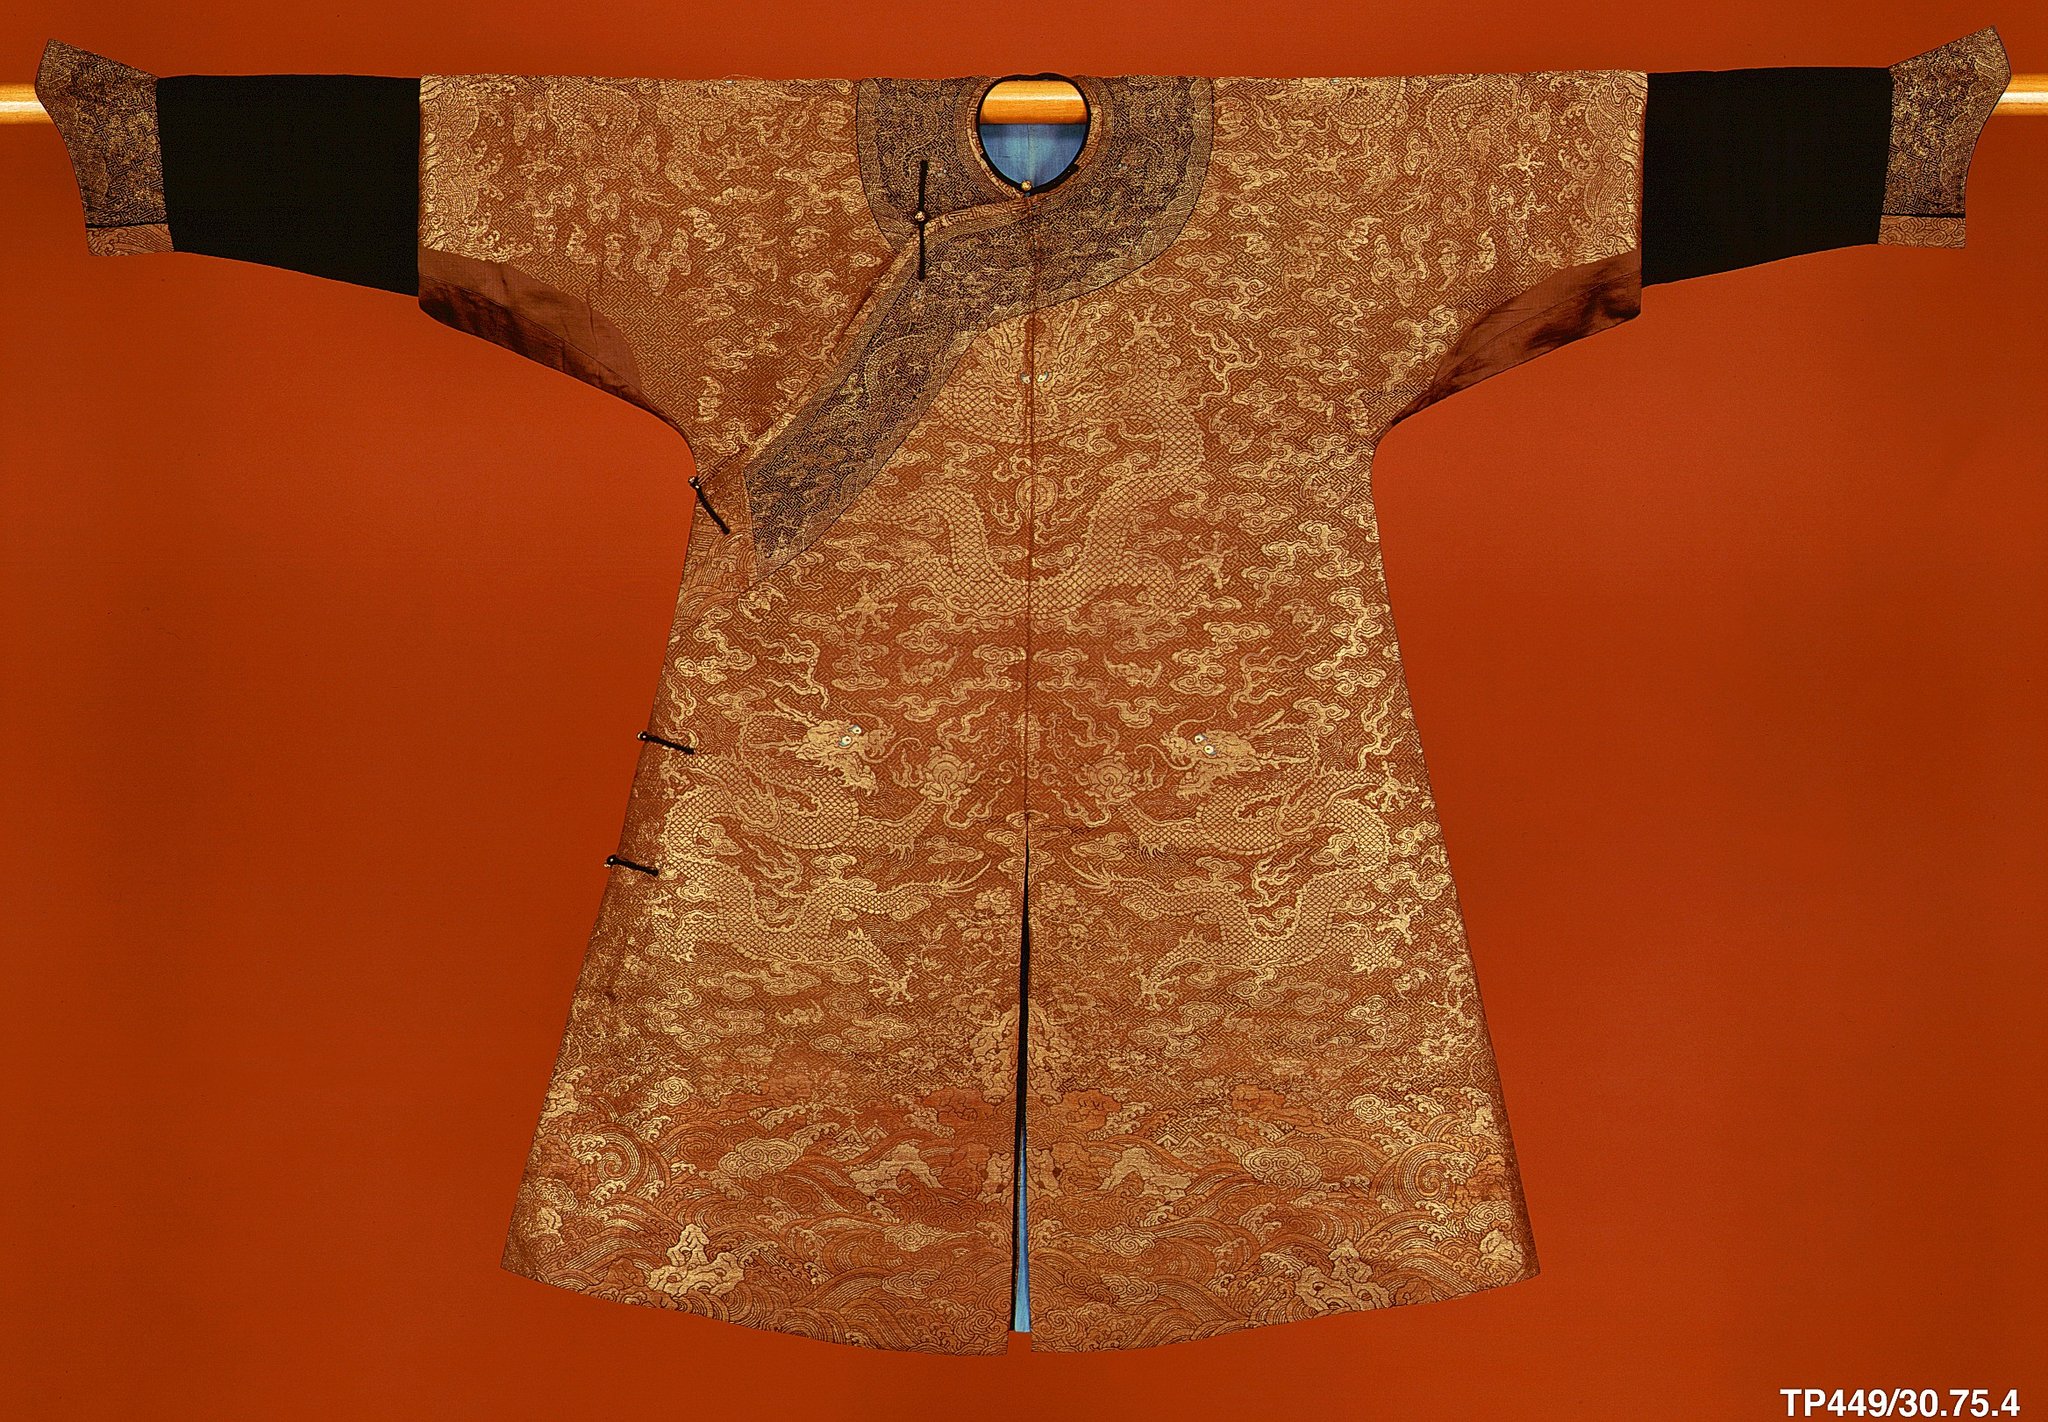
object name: robe, imperial court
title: Imperial Court Robe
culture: chinese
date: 1723-1735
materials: metal thread, silk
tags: dragons